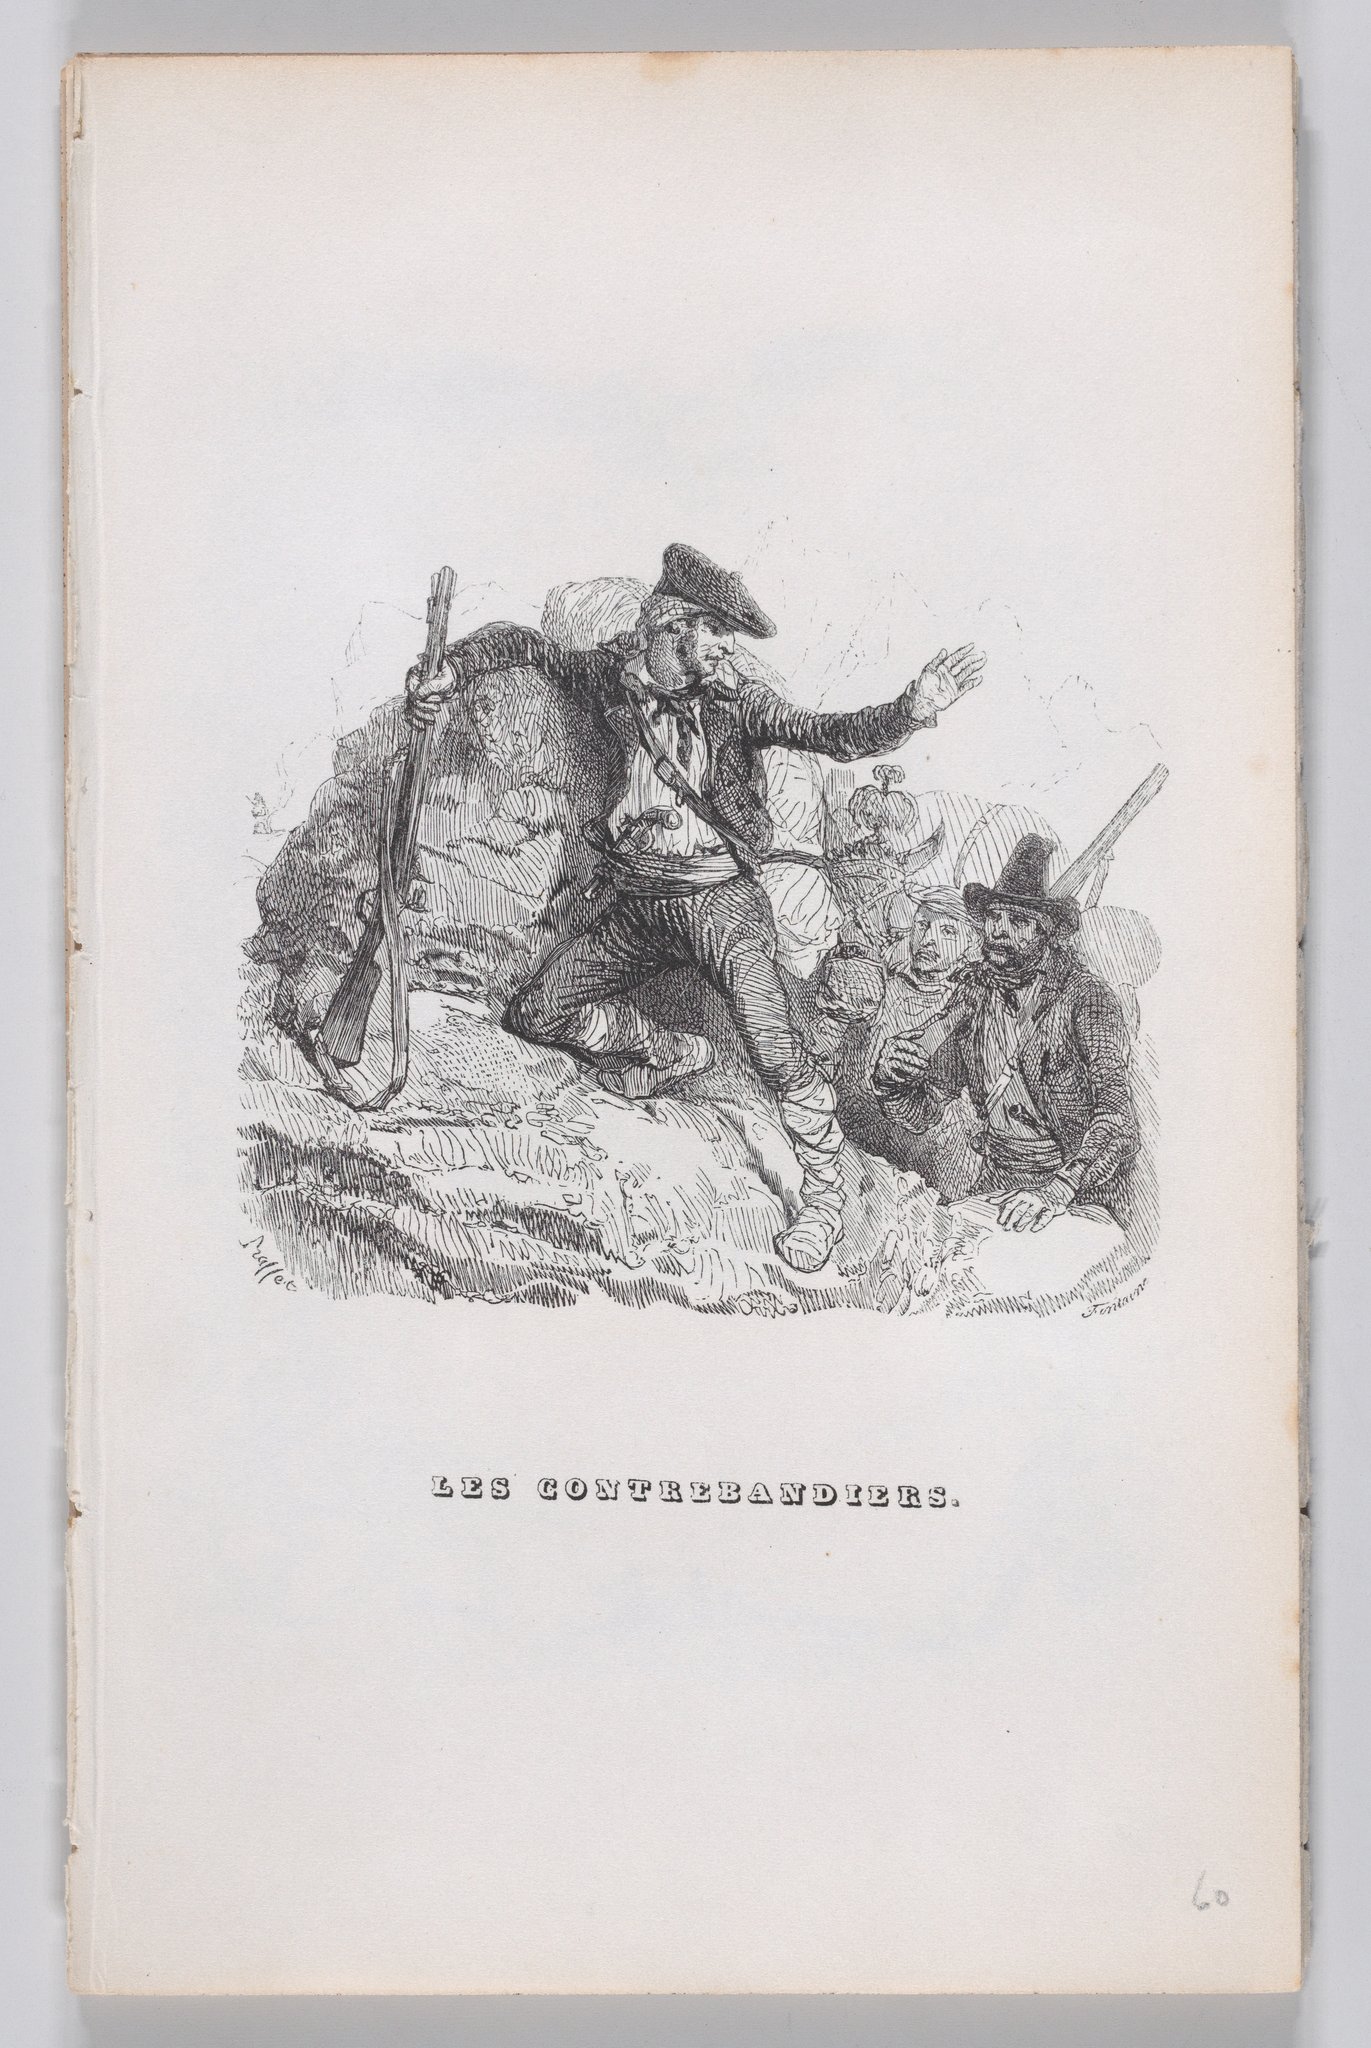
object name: print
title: The Smugglers, from "The Complete Works of Béranger"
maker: denis auguste marie raffet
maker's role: designer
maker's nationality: french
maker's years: 1804-1860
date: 1836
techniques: engraving